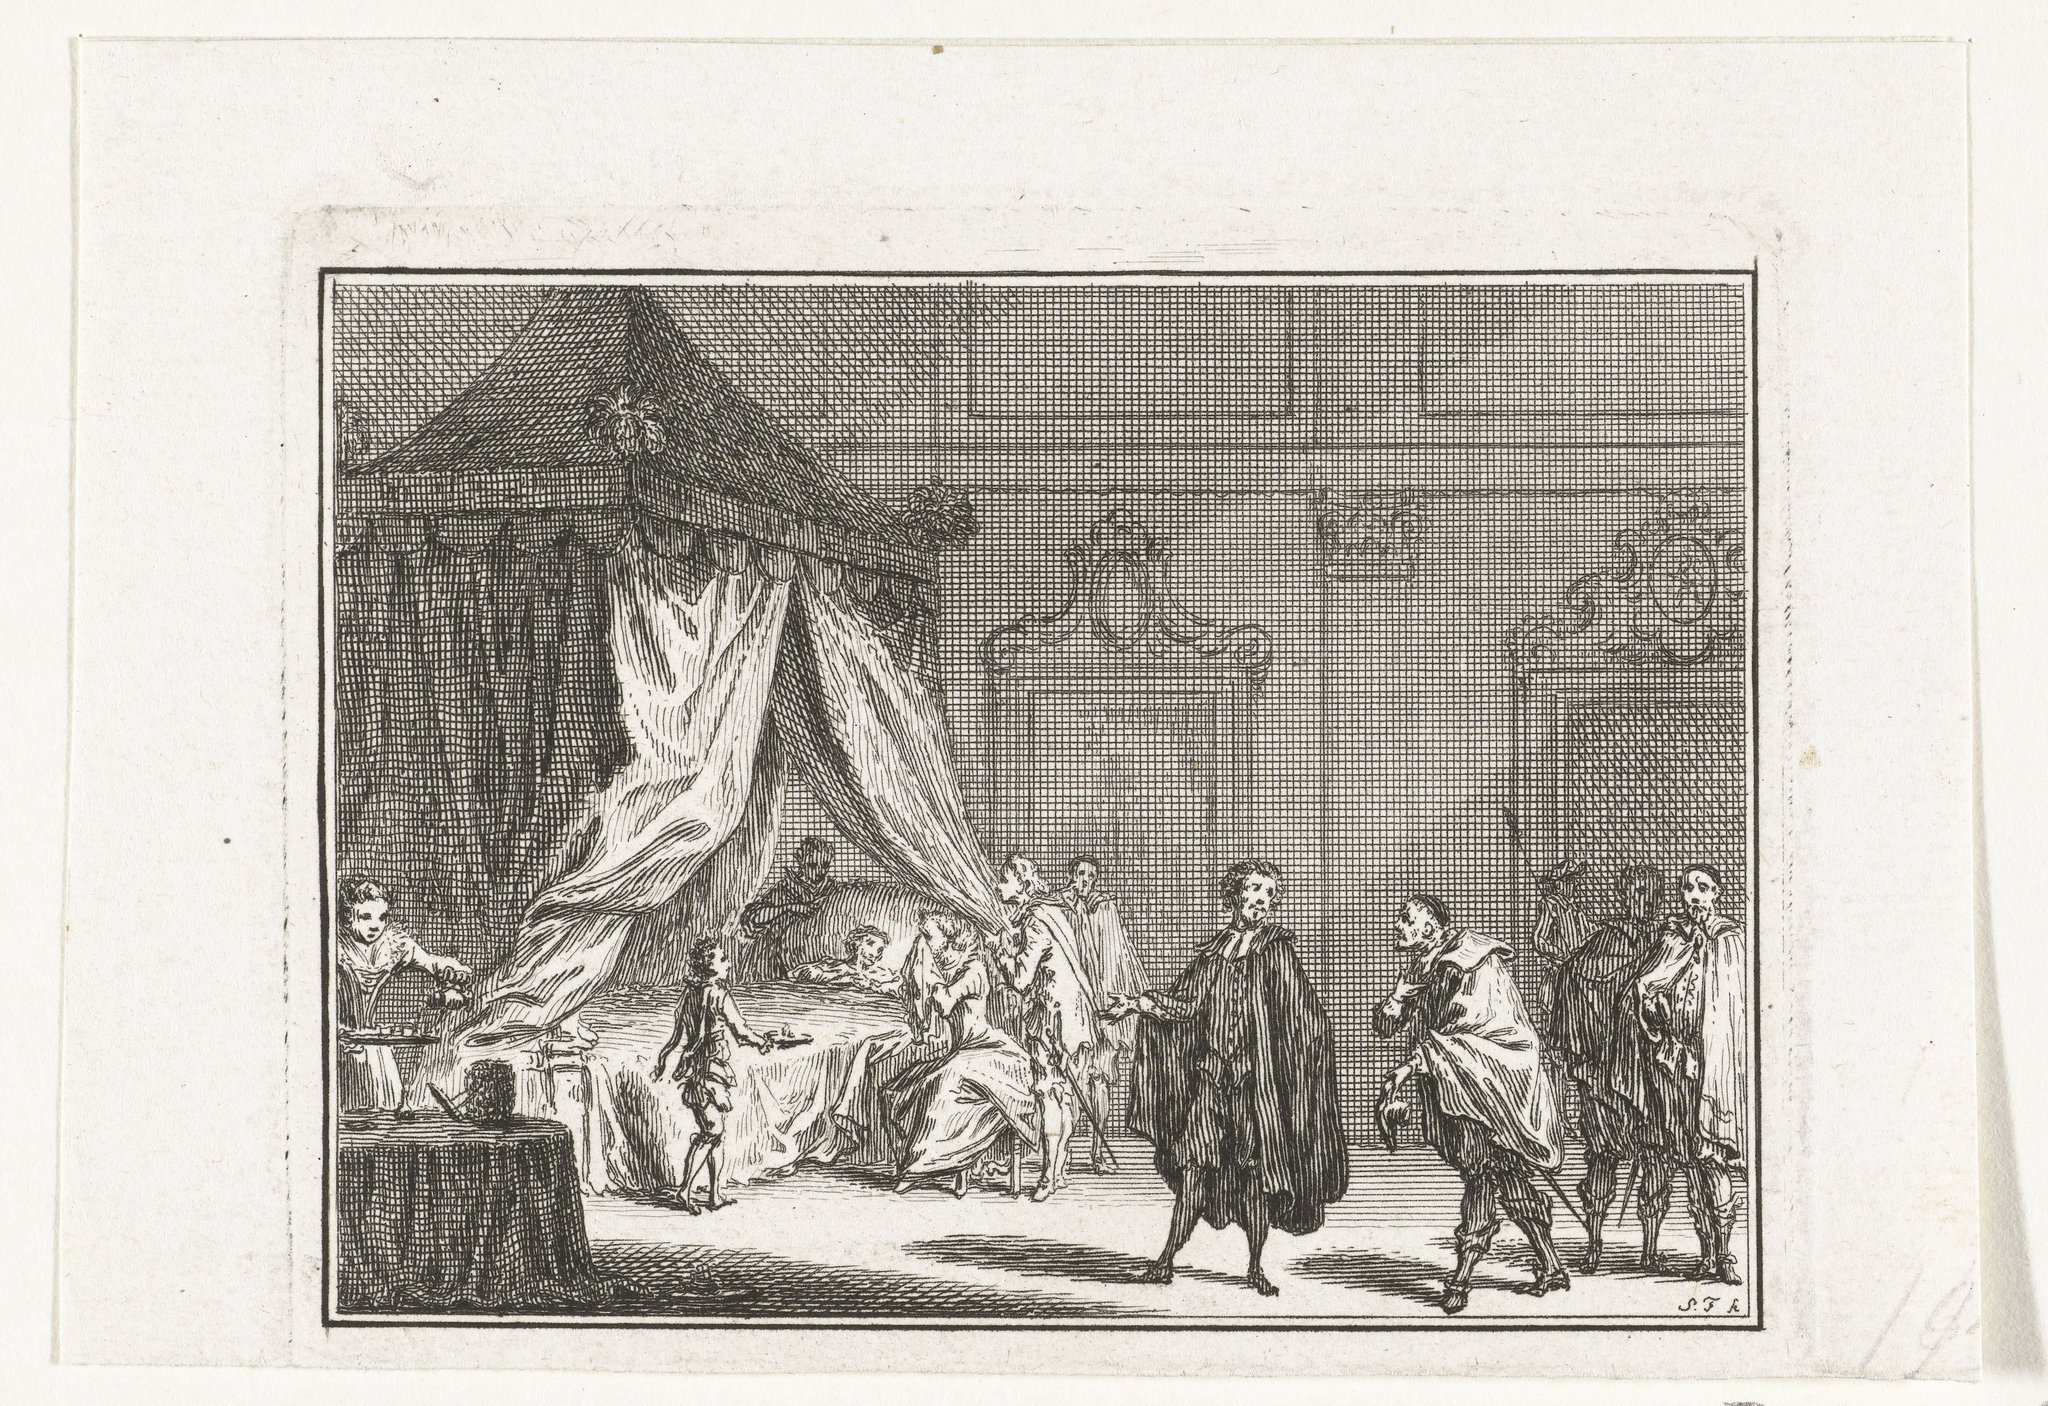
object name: history print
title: Sterfbed van Frederik Hendrik, 1647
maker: simon fokke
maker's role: draughtsman, print maker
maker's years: 1712-1784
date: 1782-1784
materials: paper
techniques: etching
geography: northern netherlands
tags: delft, frederick henry (prince of orange), william ii (prince of orange), the hague, amalia of solms-braunfels, deathbed, the death of frederick henry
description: Gebruikt als illustratie in: J.W. te Water, De vaderlandsche Historie van den heere J. Wagenaar, verkort, en met leerzaame aanmerkingen, ten dienste der Nederlandsche jeugd, 1784-1800, 4 delen. Dit nummer is een door het RPK toegevoegd nummer en staat niet in Frederik Muller, het werk waar de prent voor is gemaakt of uit afkomstig is, staat wel vermeld in Frederik Muller.